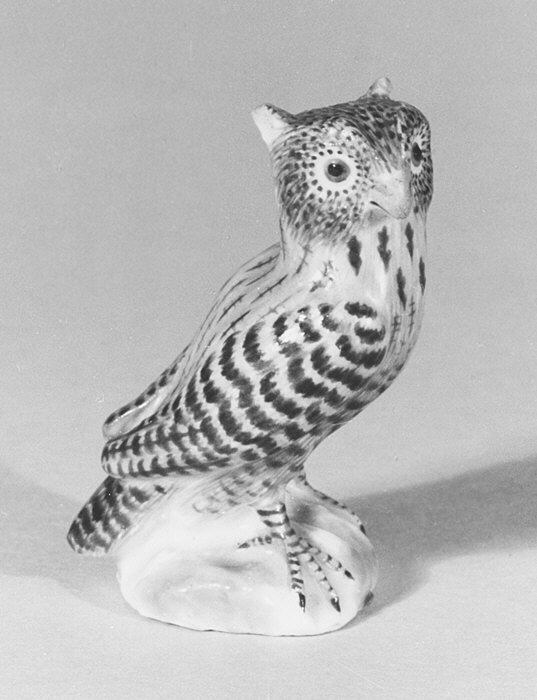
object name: figure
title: Owl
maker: meissen manufactory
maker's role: manufactory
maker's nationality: german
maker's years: 1710-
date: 1740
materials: hard paste porcelain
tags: owls